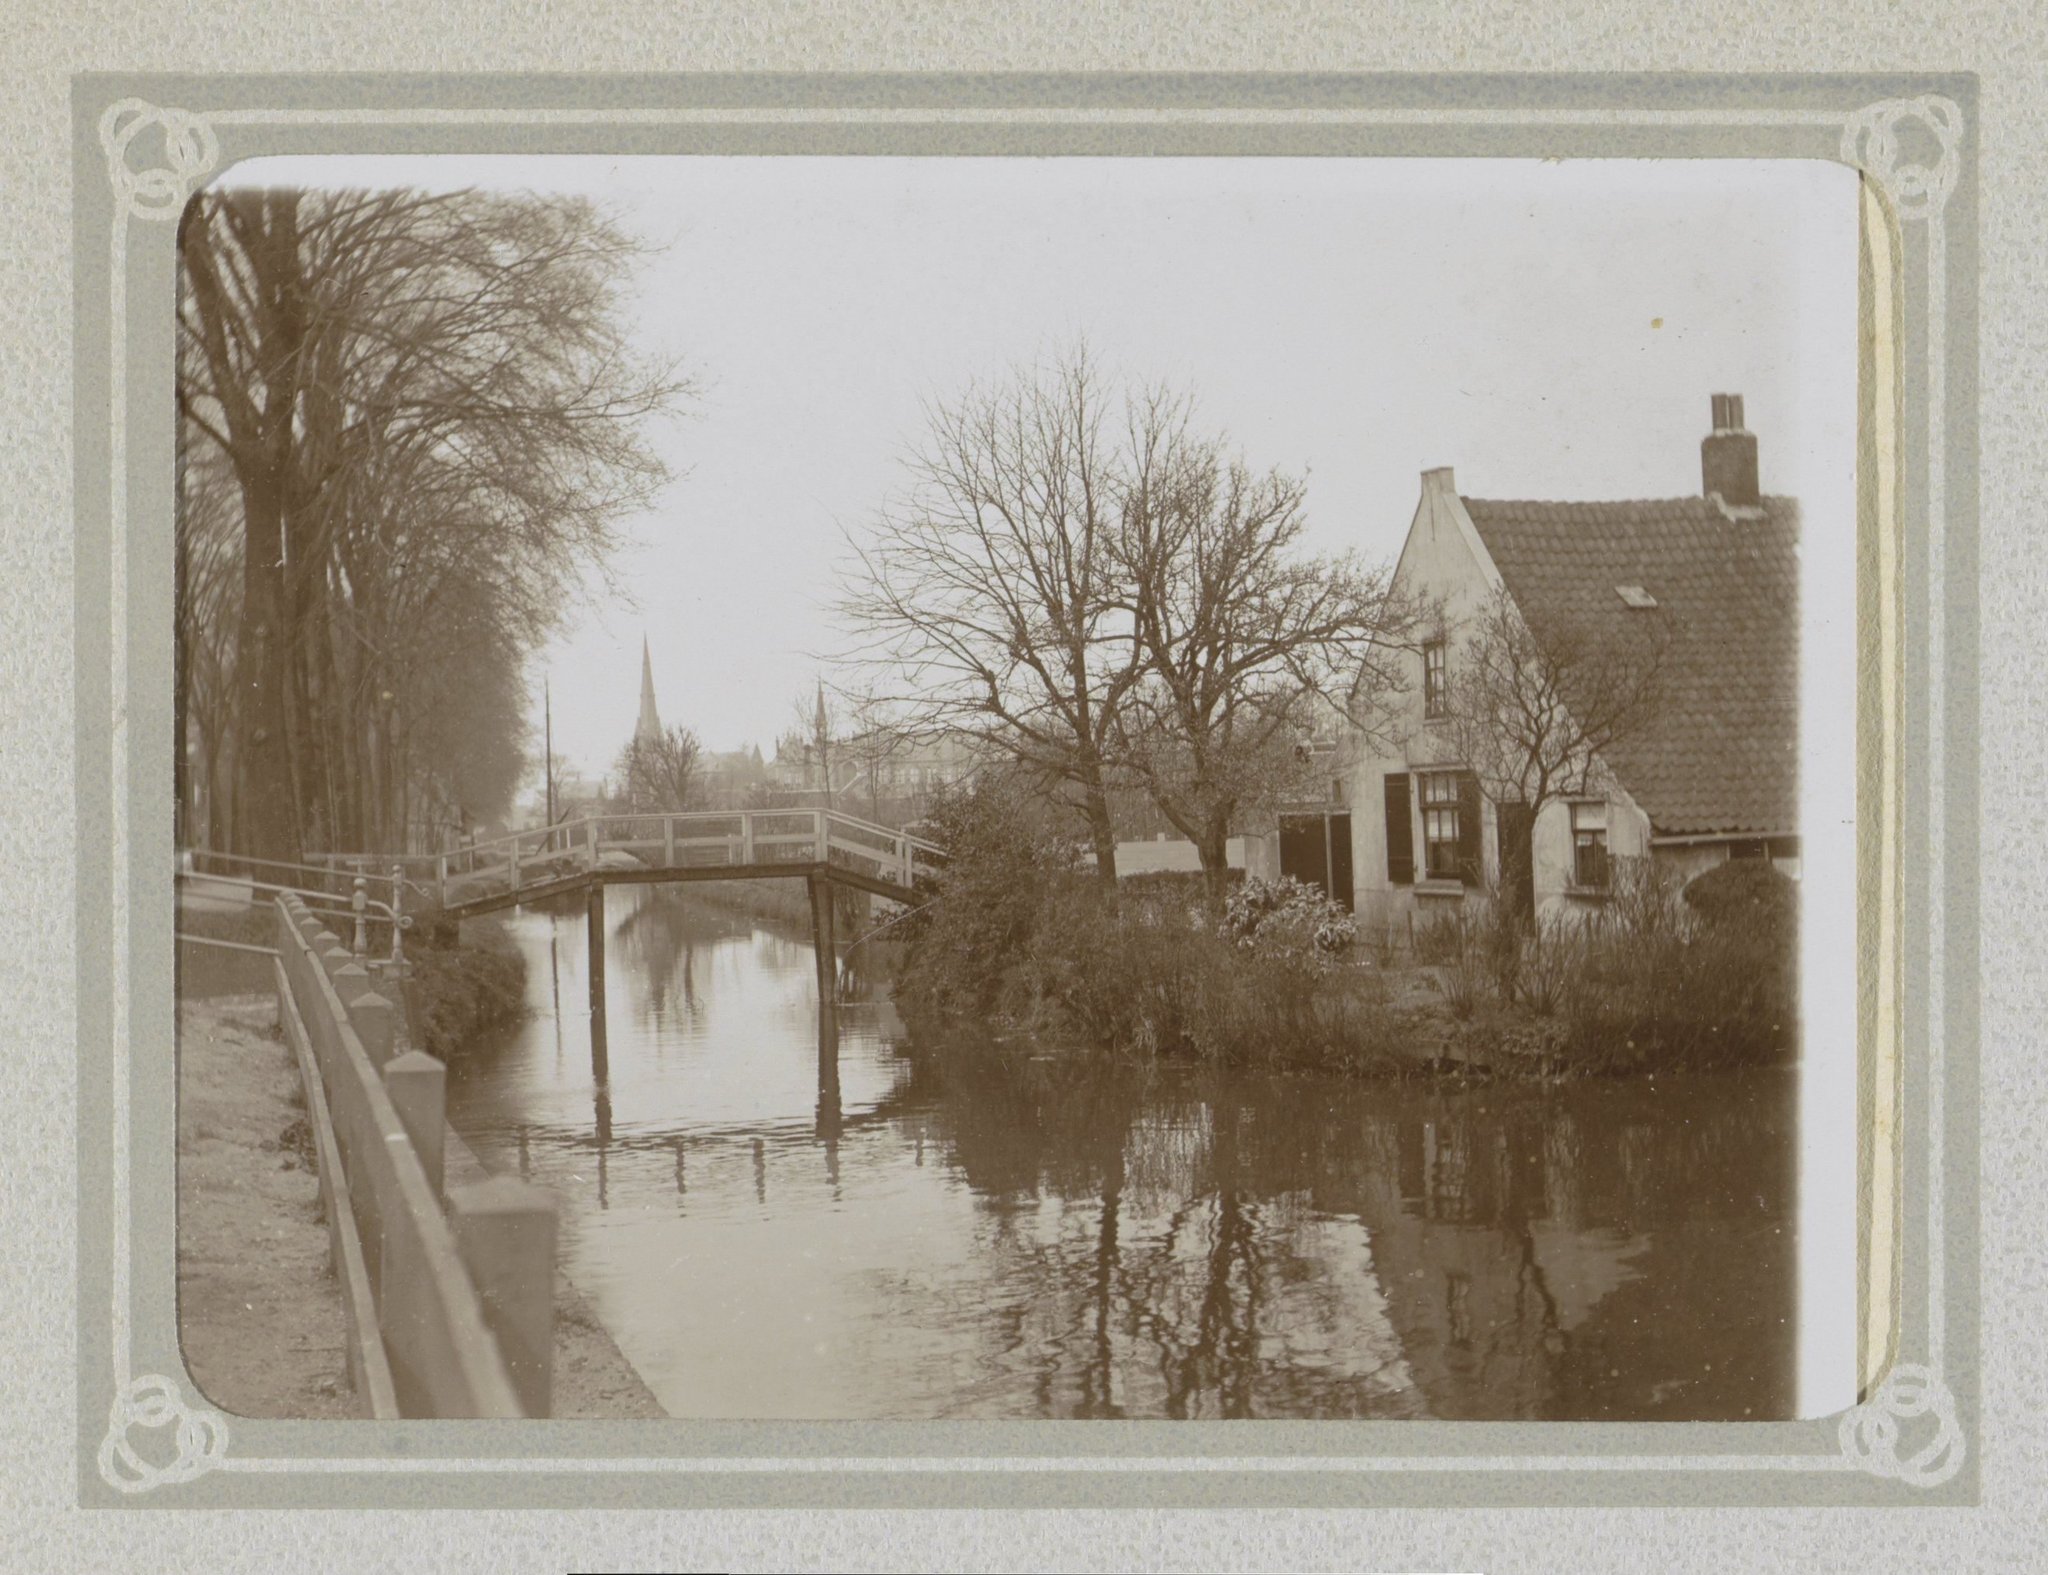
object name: photograph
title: Huis aan een water met een brug, aan de horizon twee torens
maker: folkert idzes de jong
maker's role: architect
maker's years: 1877-1929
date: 1905-1907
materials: photographic support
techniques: collodion silver print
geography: heemstede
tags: rural housing, e.g. country-house, villa, cottage, bridge, small canal, ditch, parts of church exterior and annexes: tower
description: Onderdeel van Topografisch album van Nederlandse dorpen en steden 1905.